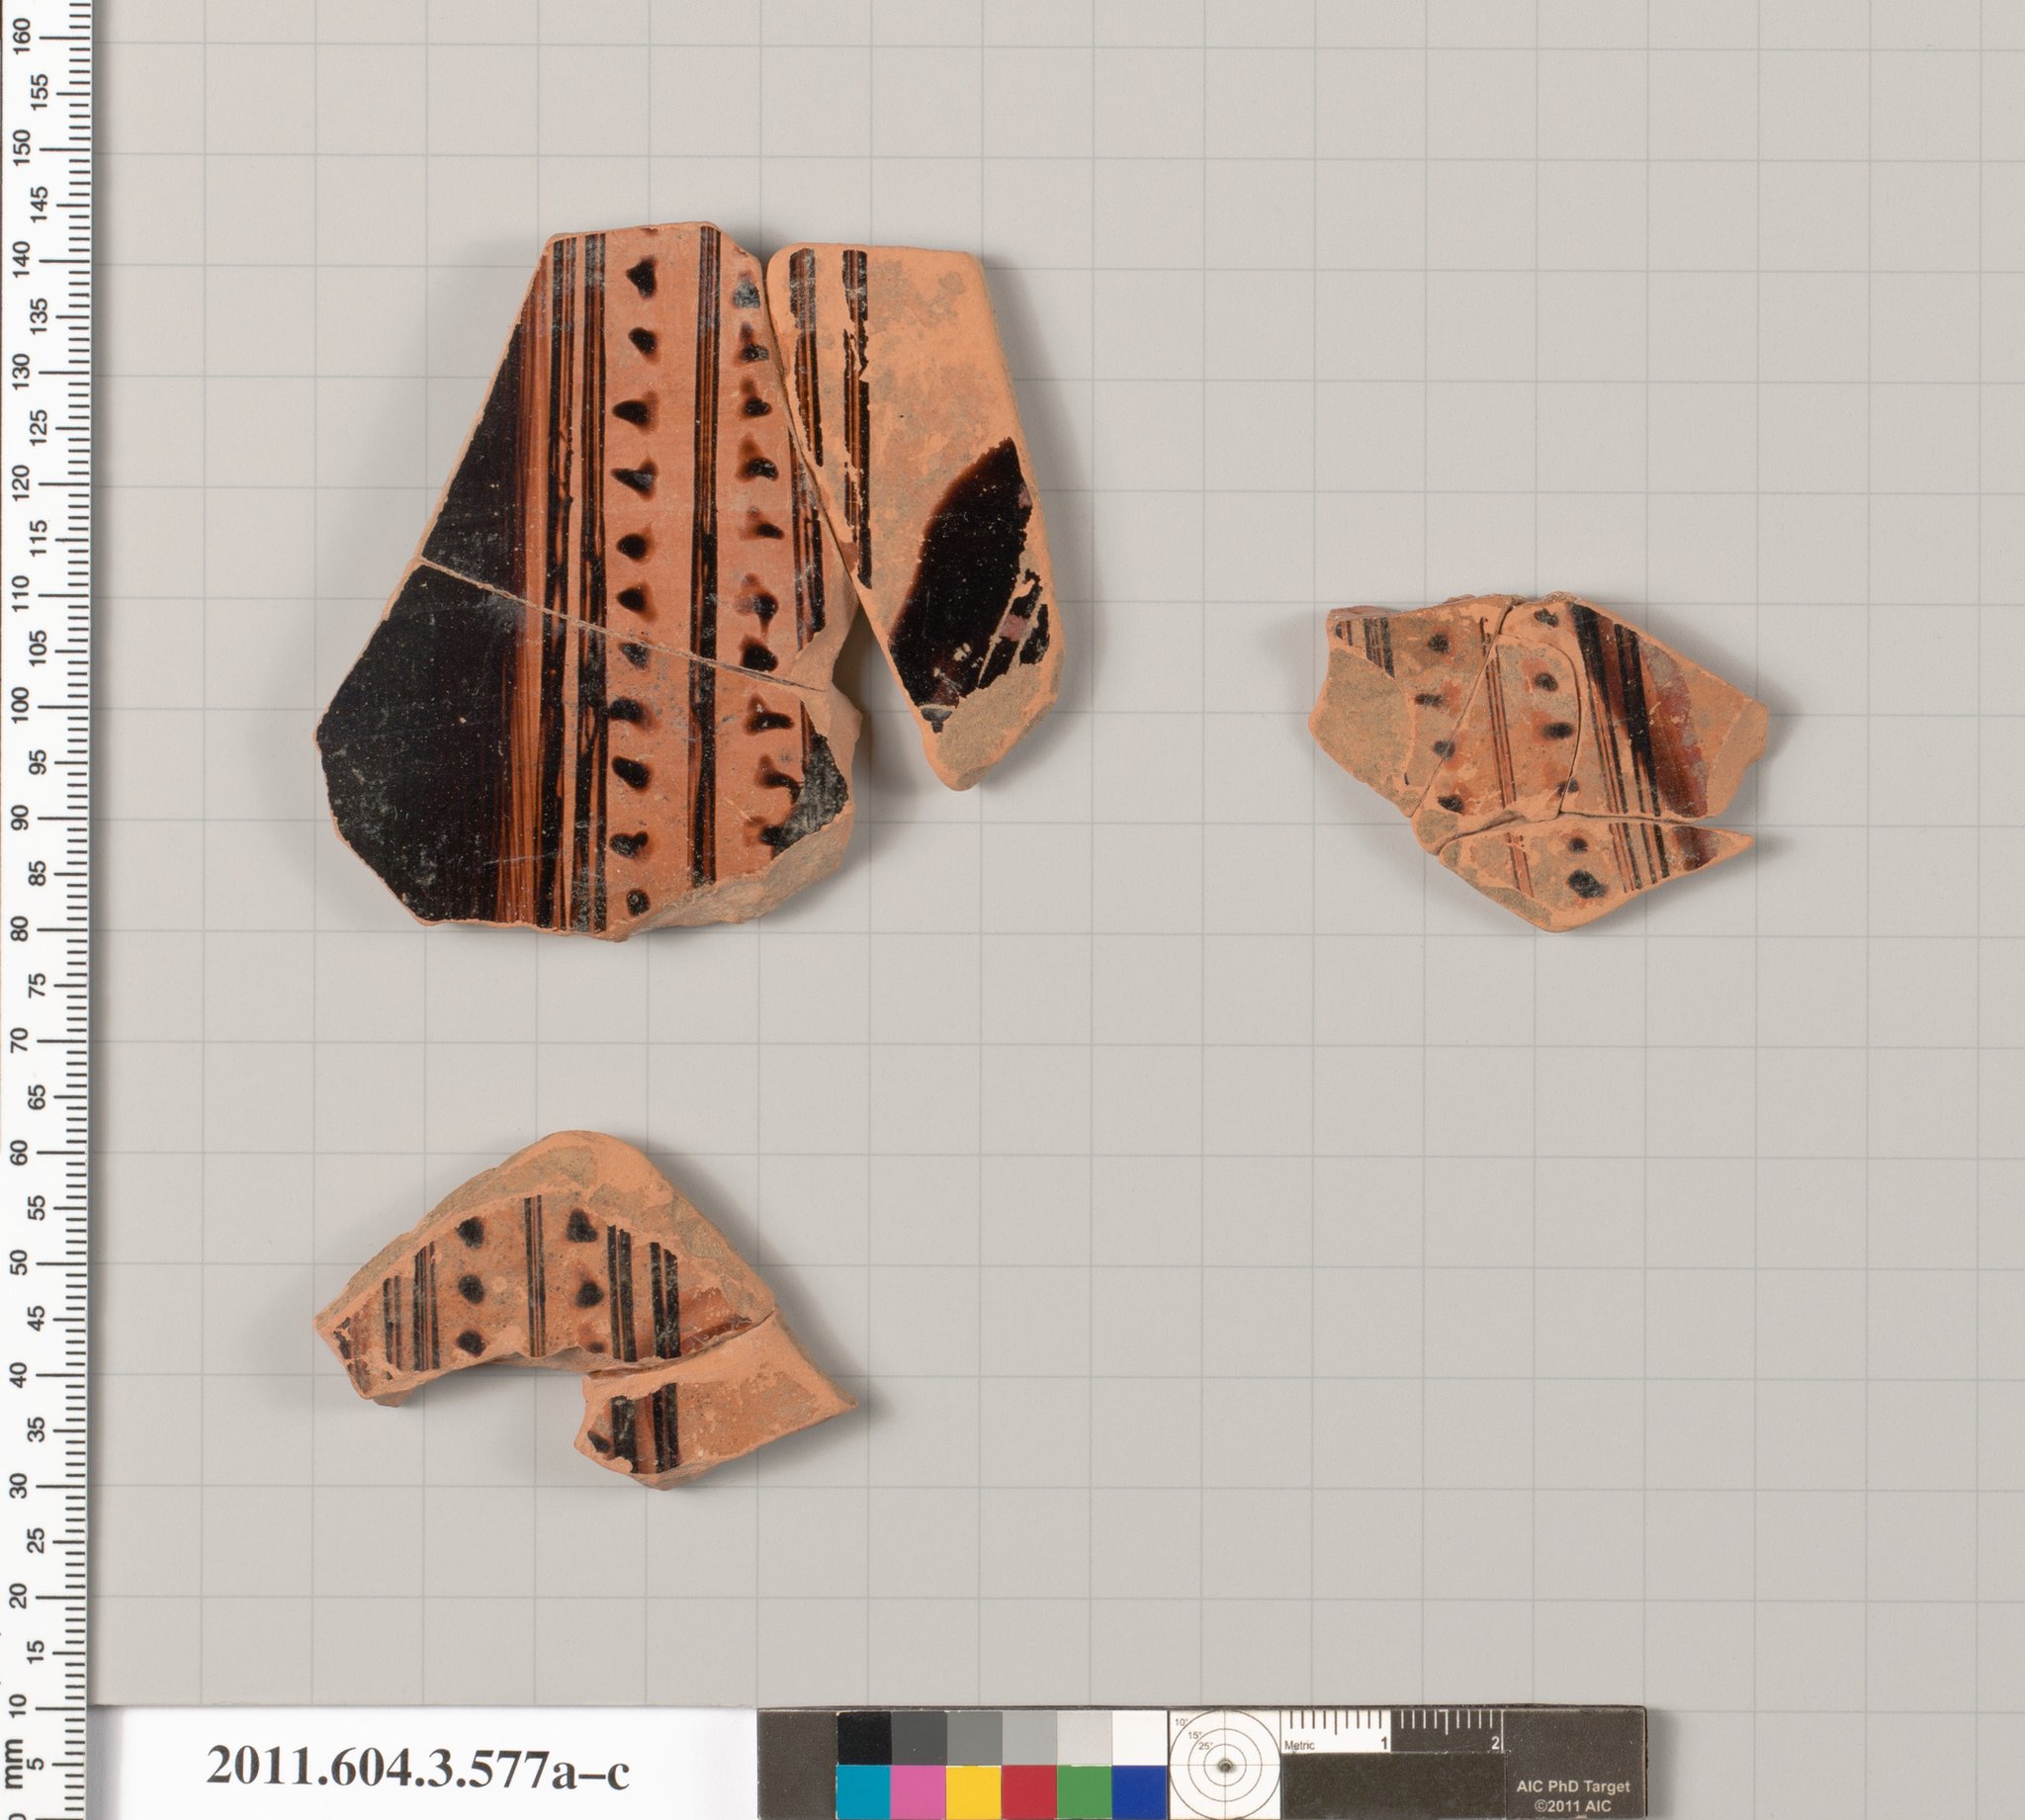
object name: column krater fragment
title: Terracotta fragments of a column-krater (bowl for mixing wine and water)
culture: greek, attic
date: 534-501 BCE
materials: terracotta